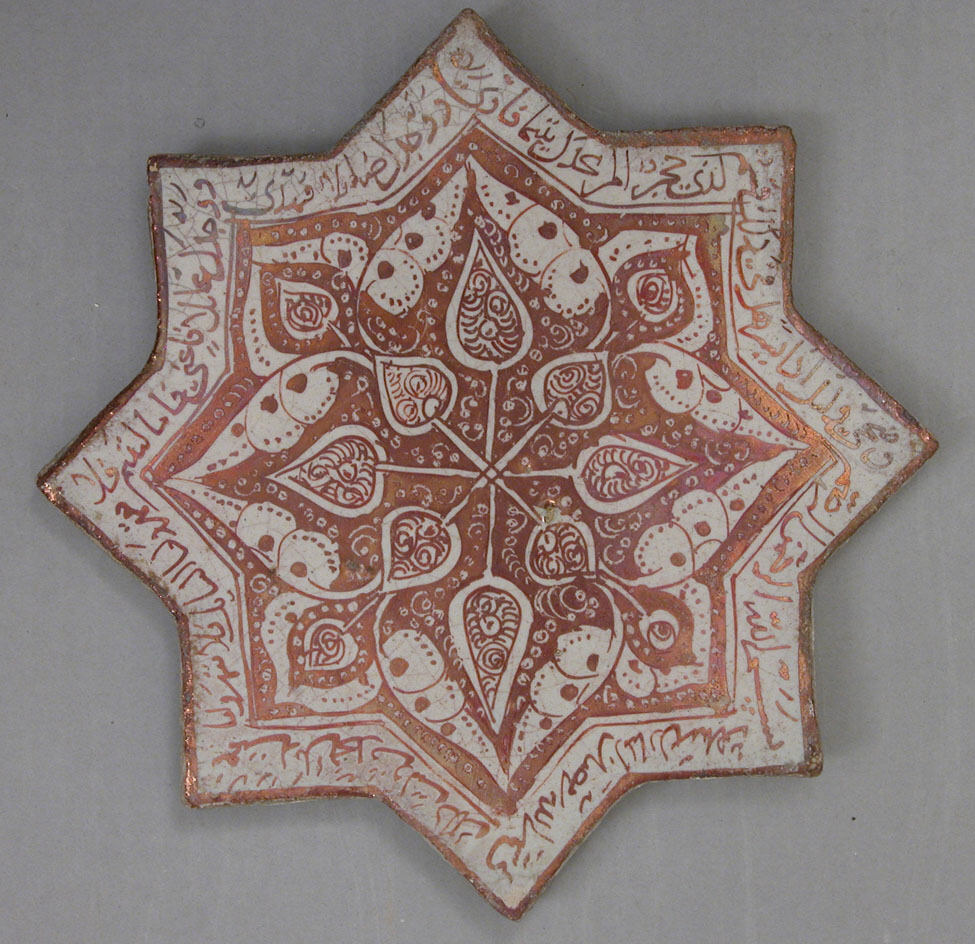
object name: tile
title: Star-Shaped Tile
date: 1201-1300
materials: cobalt, glaze, stonepaste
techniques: luster painting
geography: iran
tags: leaves